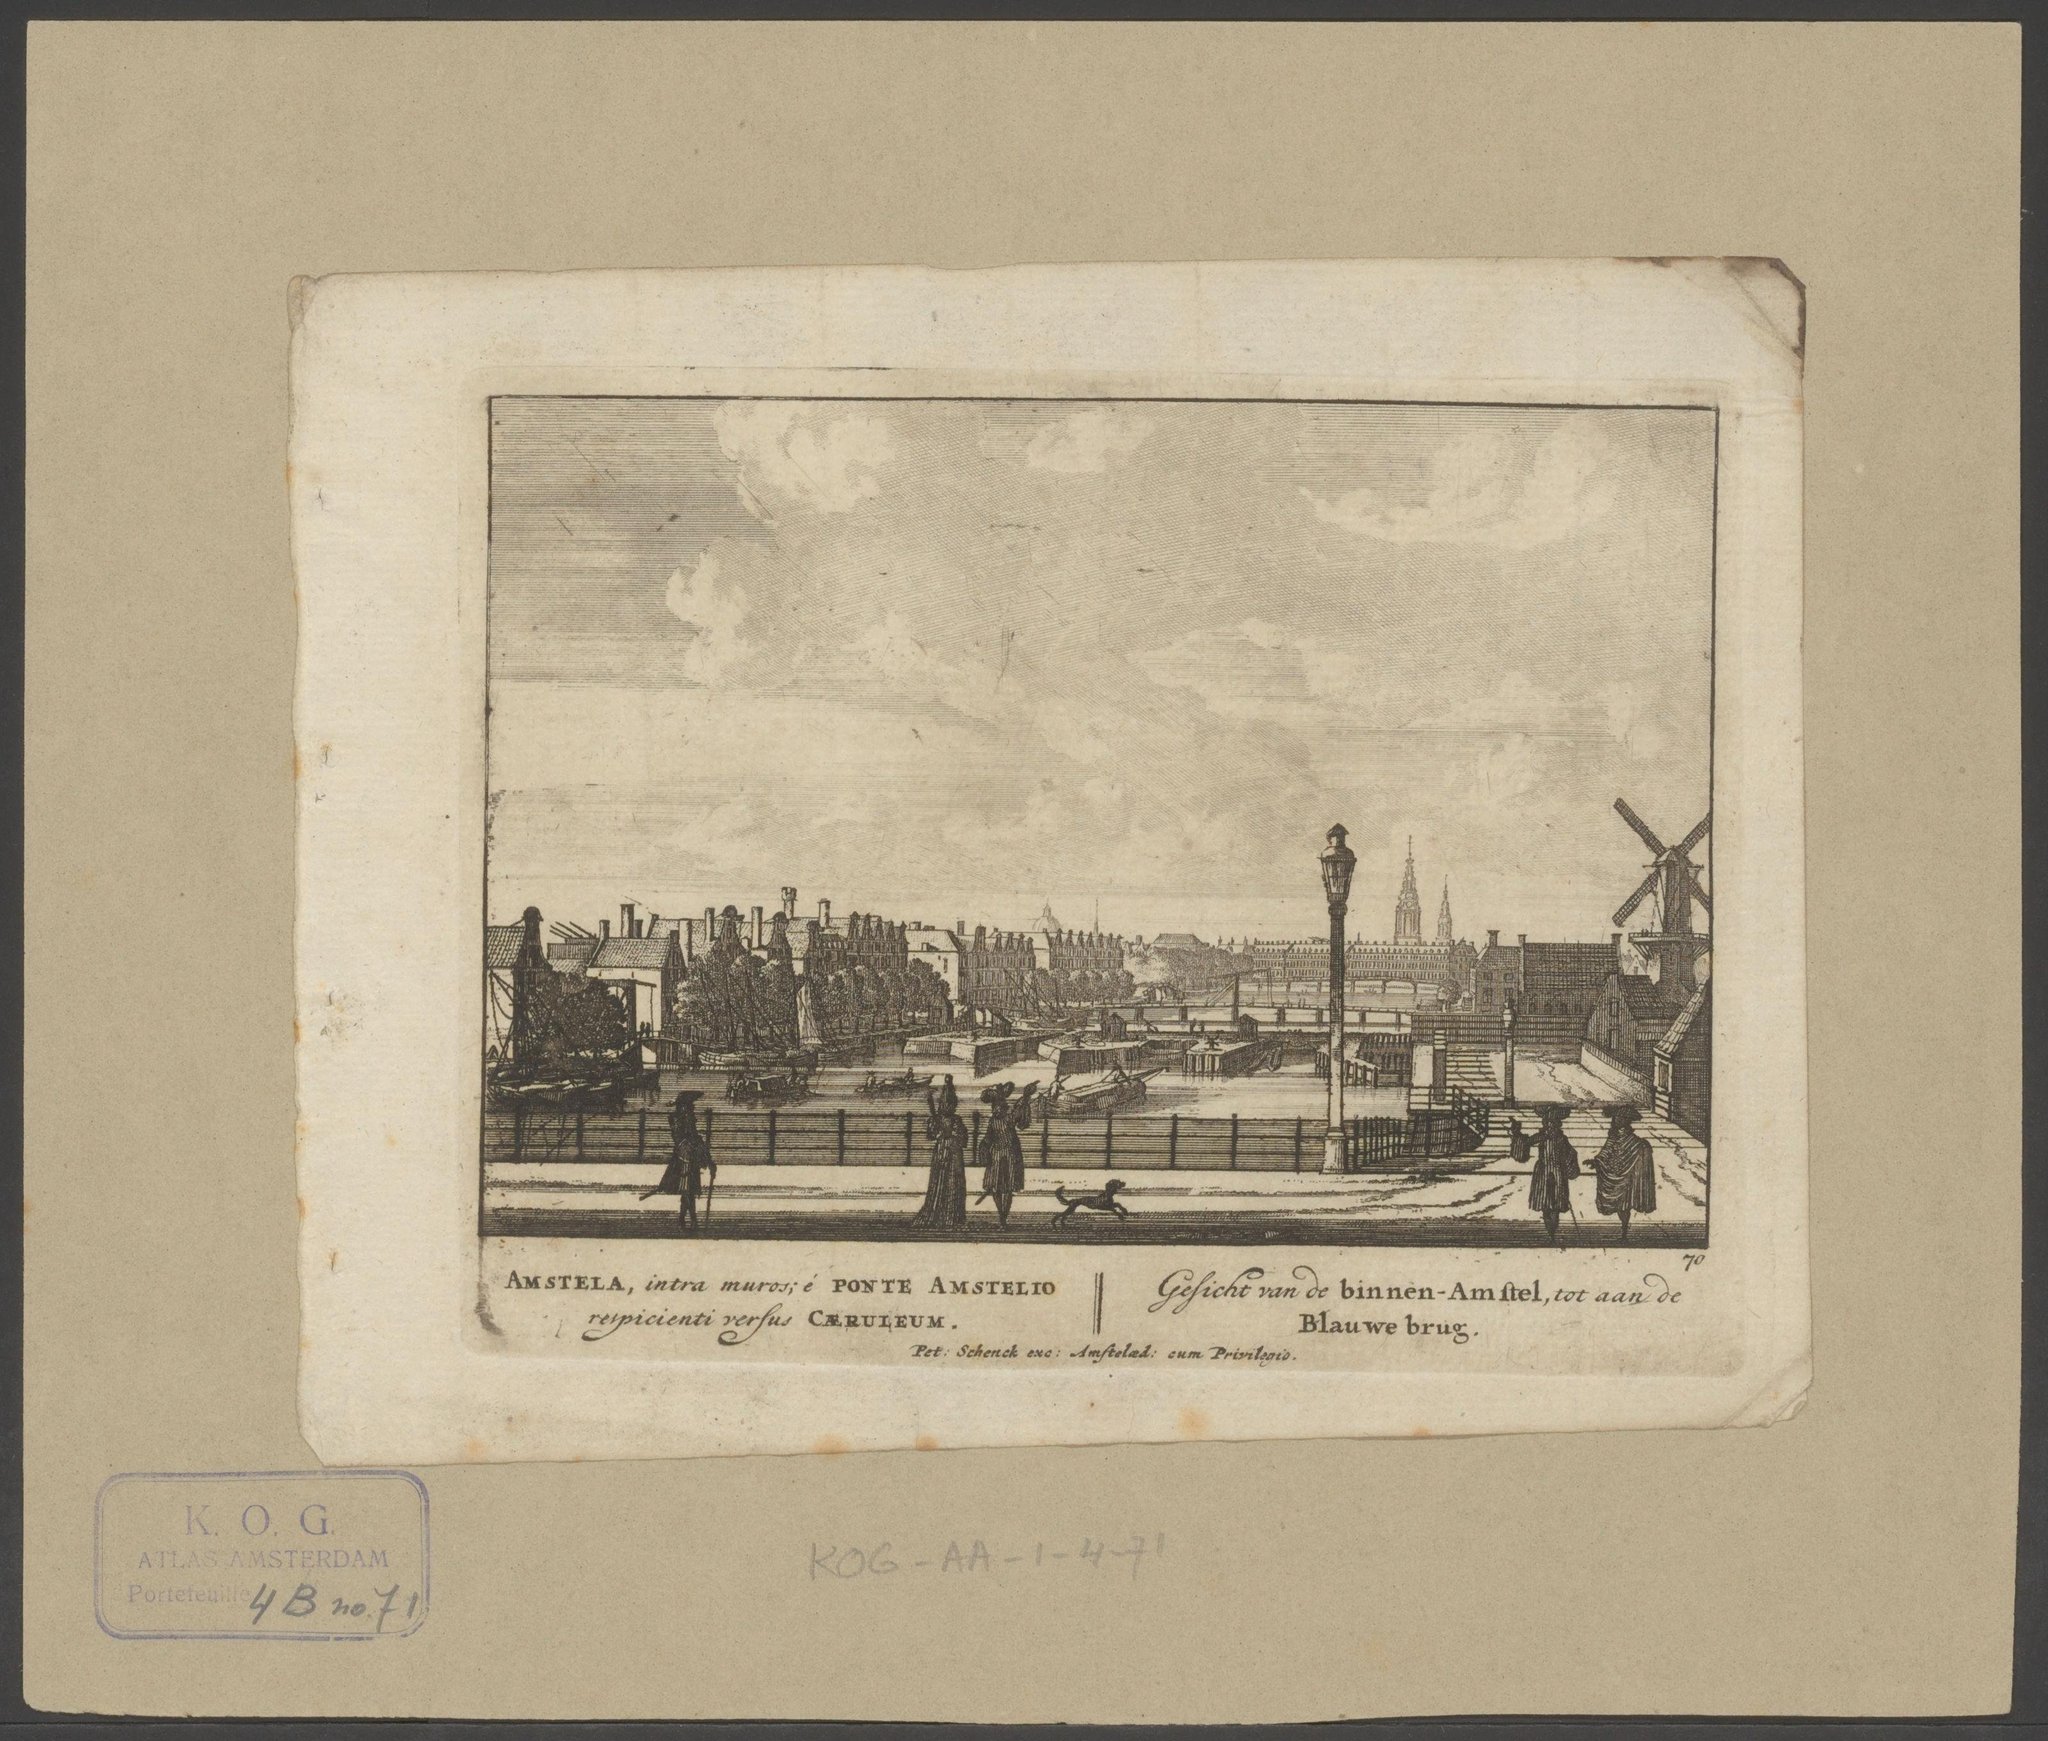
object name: print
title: Gezicht op de Binnen-Amstel te Amsterdam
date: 1694-1697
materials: paper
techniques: etching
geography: amsterdam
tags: sluice, weir, city-view in general; 'veduta', canal, bridge in city across river, canal, etc.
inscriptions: collector's mark: ‘4B no 71’ Lugt 1641b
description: Andere staat ook gebruikt in: Call, Jan van. Admirandorum Quadruplex Spectaculum. Amsterdam: Pieter Schenk (I), 1700. De titelprent, opdracht en het portret van Frederik van Saksen zijn gegraveerd door Pieter Schenk (I). De overige prenten uit deze serie zijn, zoals aangegeven op de titelprent, van de hand van Jan van Call (I).